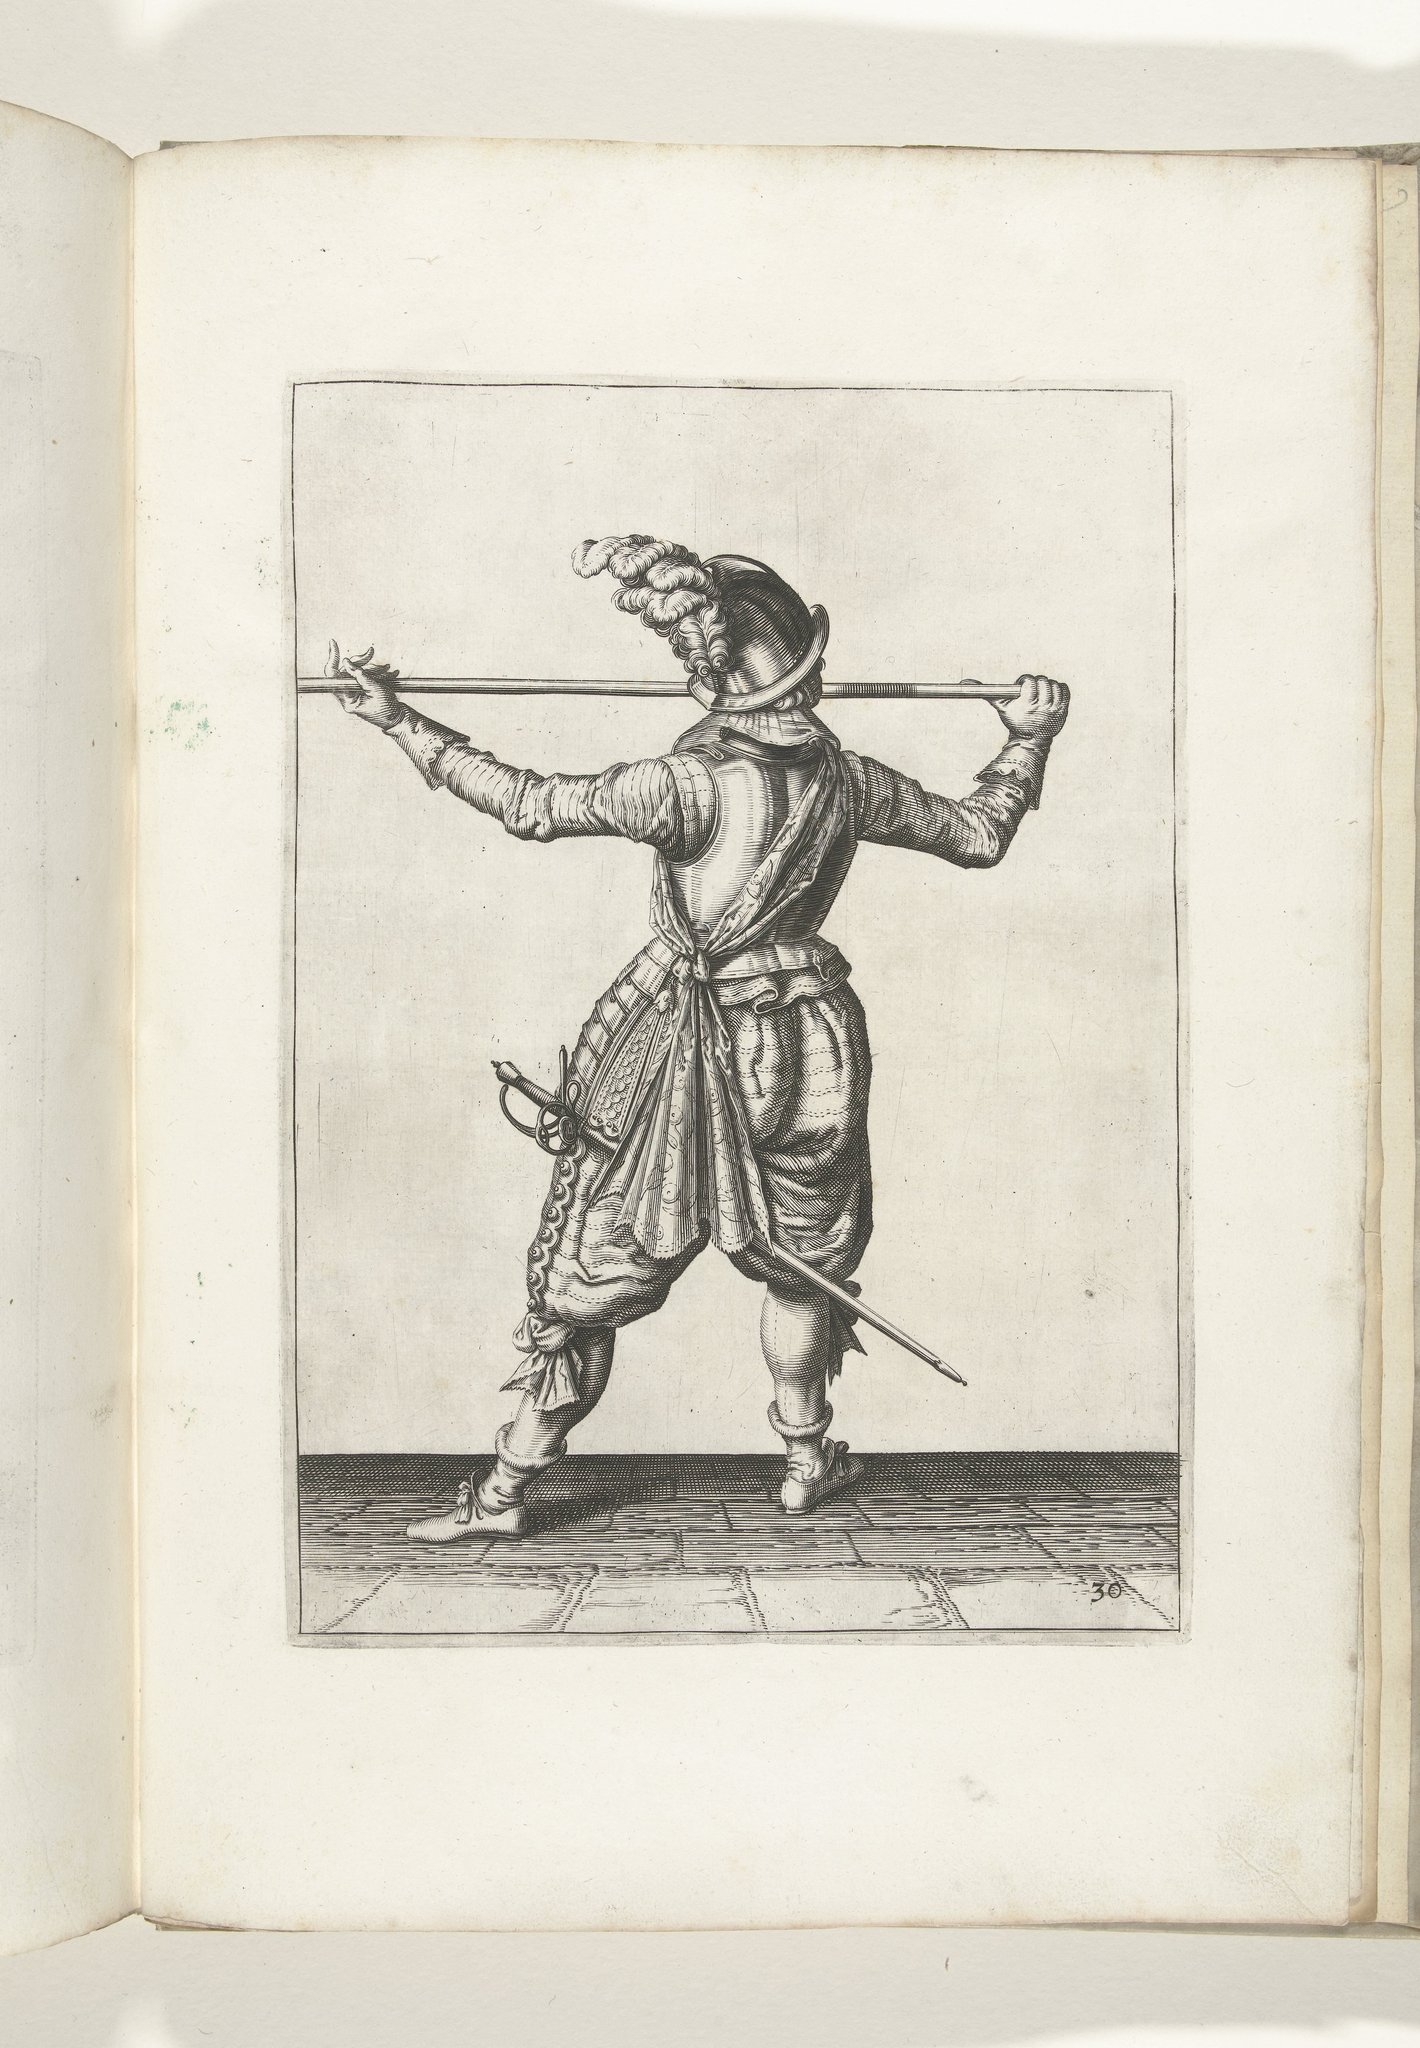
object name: print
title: Soldaat, op de rug gezien, die zijn spies met beide handen horizontaal op neushoogte draagt, zijn rechterhand bij de voet van het wapen, zijn gezicht naar rechts gewend (nr. 30), ca. 1600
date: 1597-1607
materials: paper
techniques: engraving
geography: northern netherlands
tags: the hague, maurice (prince of orange), handling of weapons ~ military training, weapons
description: Een soldaat, ten voeten uit, op de rug gezien, die een spies (lans) met beide handen horizontaal op neushoogte draagt, zijn rechterhand bij de voet van het wapen, zijn gezicht naar rechts gewend (nr. 30), ca. 1600. Plaat 30 in de instructies voor het hanteren van de spies: Corte onderwysinghe op de figuerliicke afbeeldinghe, belanghende t'recht ghebruyck, van al t'ghene een Soldaet int handelen vande Spies noodich is. Onderdeel van de illustraties in: J. de Gheyn, Wapenhandelinghe van Roers Musquetten ende spiessen, 's-Gravenhage, 1607. Krijgswezen rond 1600.